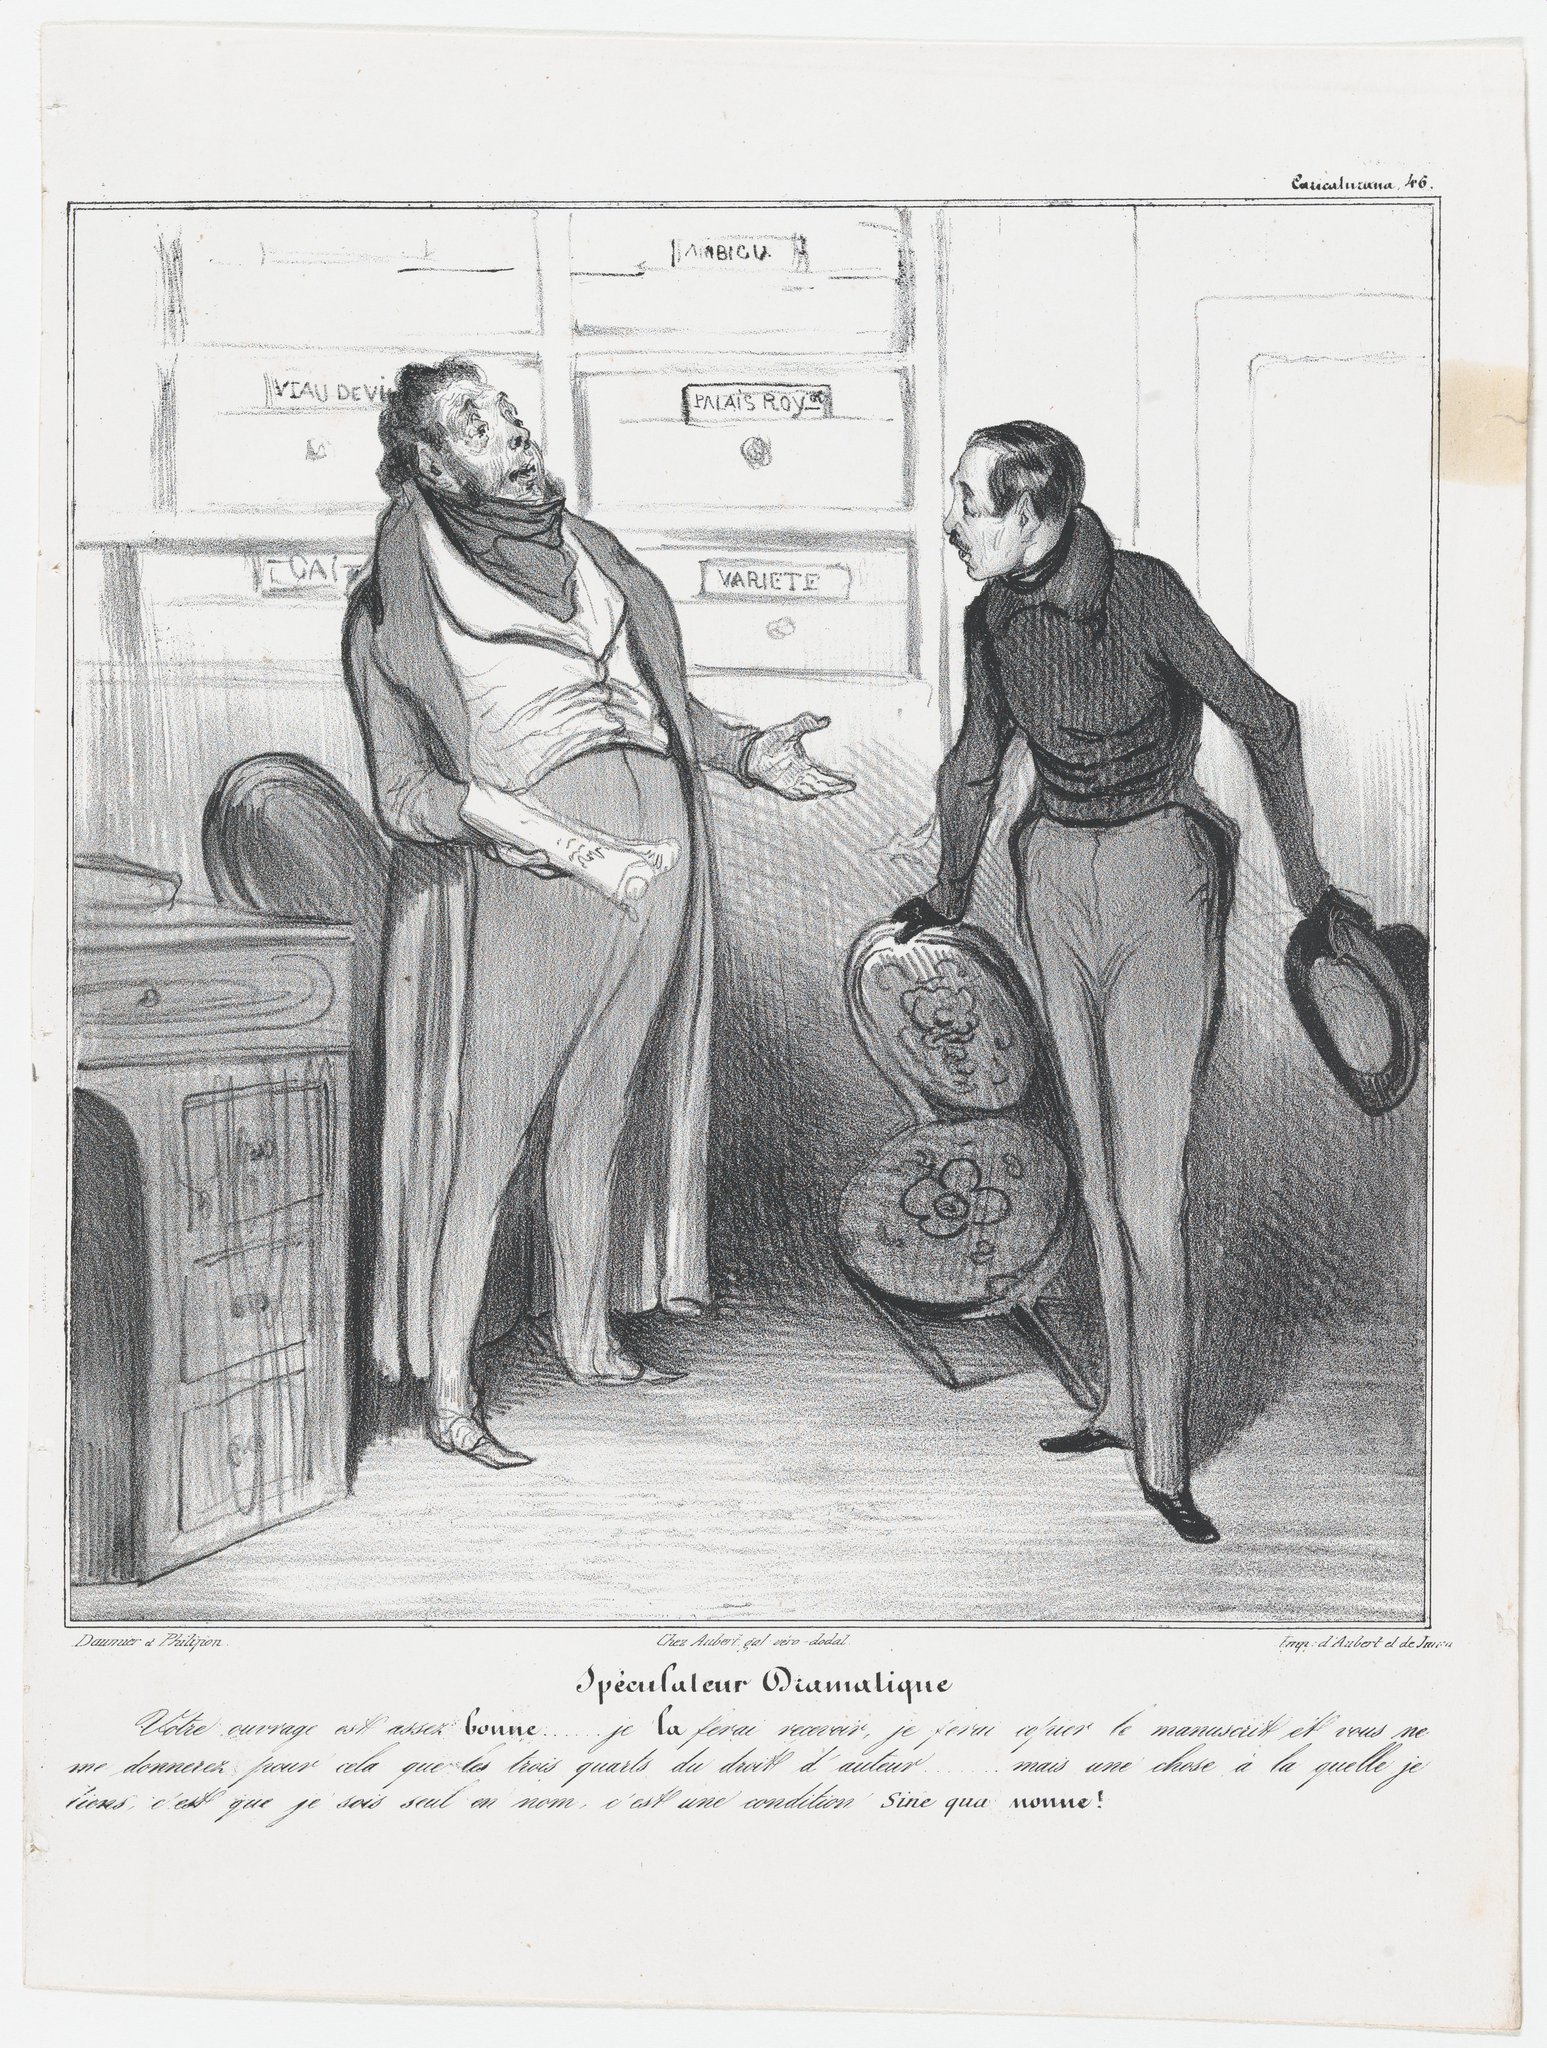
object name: print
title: Plate 46: Theatrical agent, from 'Caricaturana,' published in Les Robert Macaires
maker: honoré daumier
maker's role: artist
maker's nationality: french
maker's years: 1808-1879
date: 1838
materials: paper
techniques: lithograph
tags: men